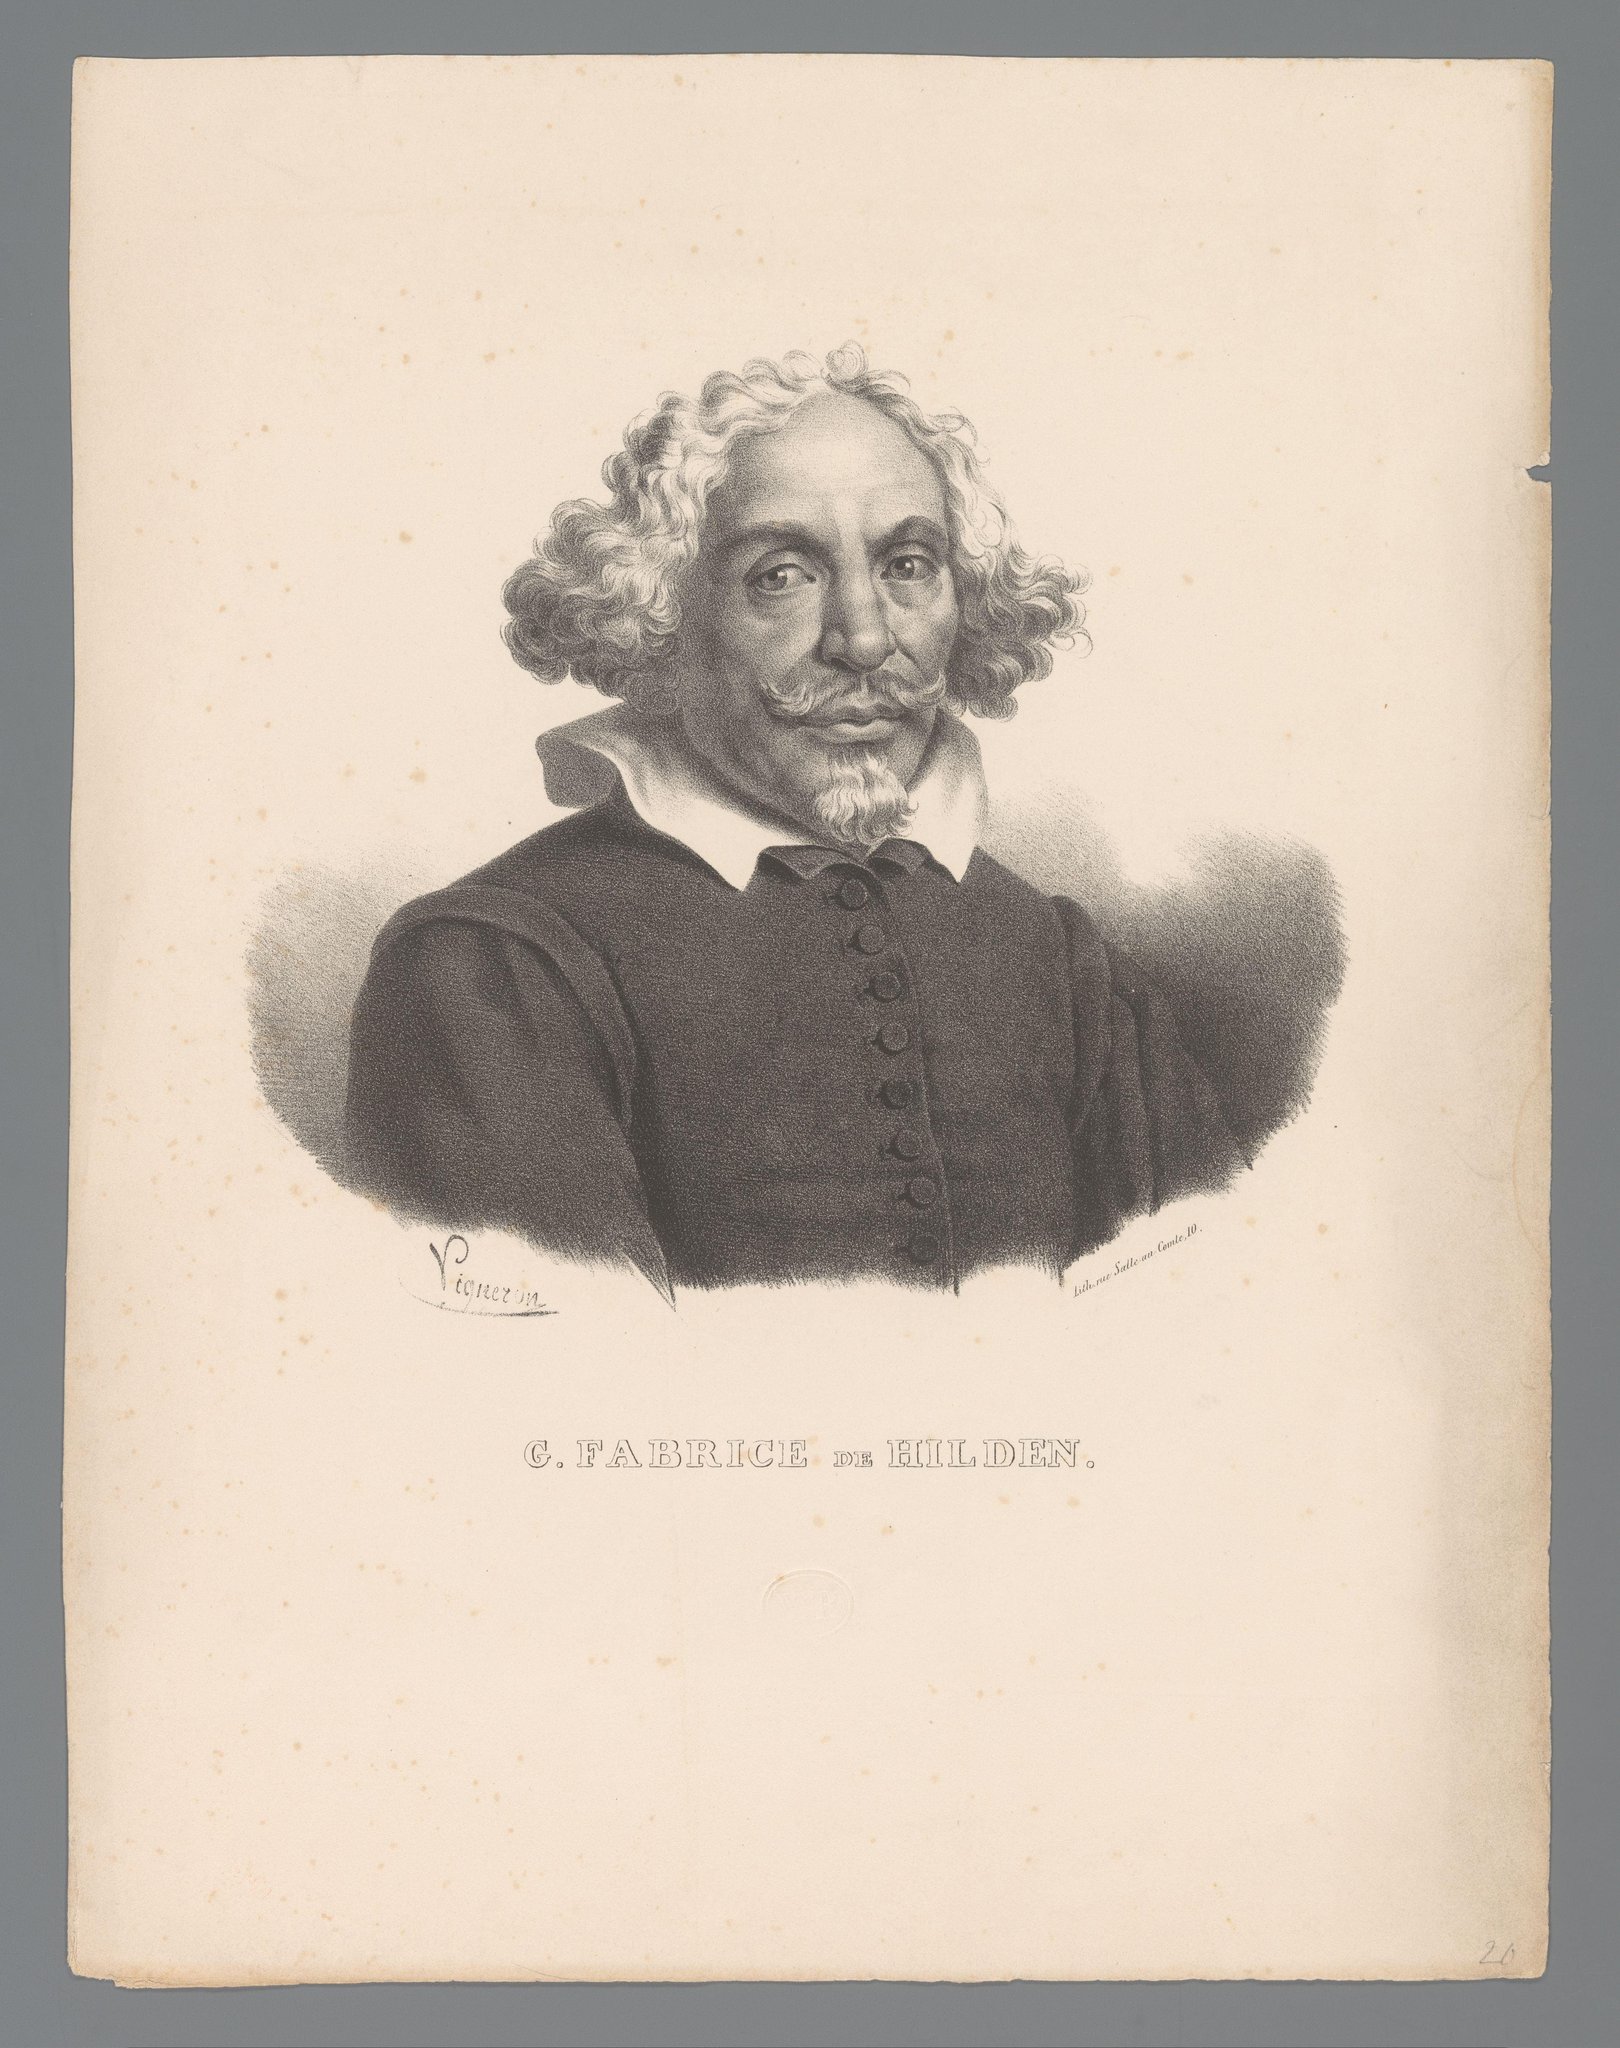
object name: print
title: G. Fabrice de Hilden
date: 1830-1853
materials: paper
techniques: lithograph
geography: paris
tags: historical persons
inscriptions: check stamp: Lugt 3693